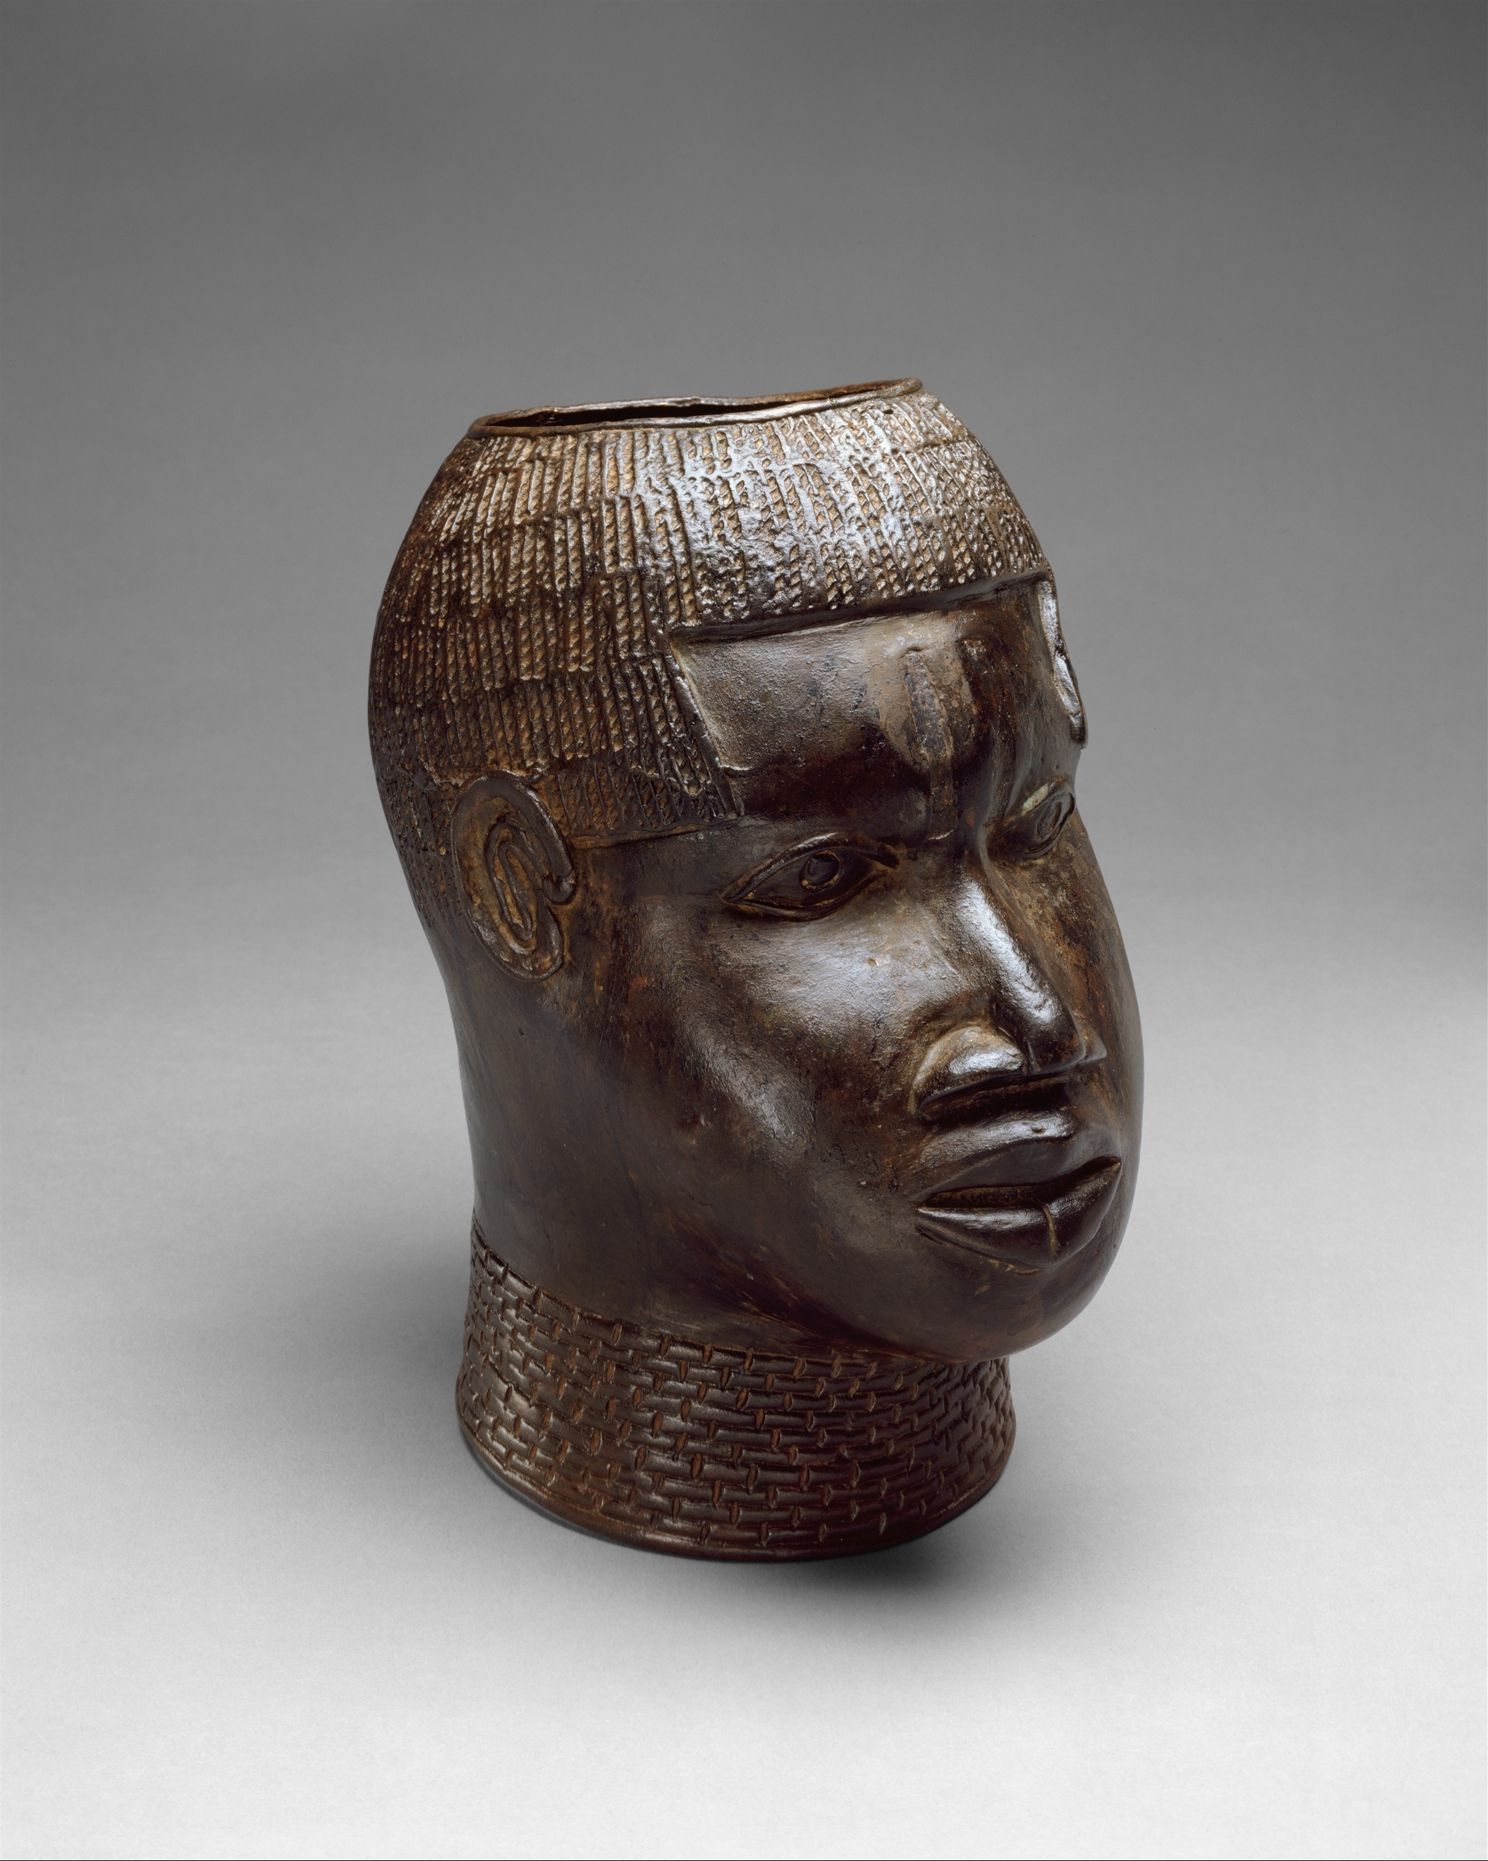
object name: head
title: Figure: Male Head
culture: edo period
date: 1401-1900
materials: brass, iron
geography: nigeria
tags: heads,men